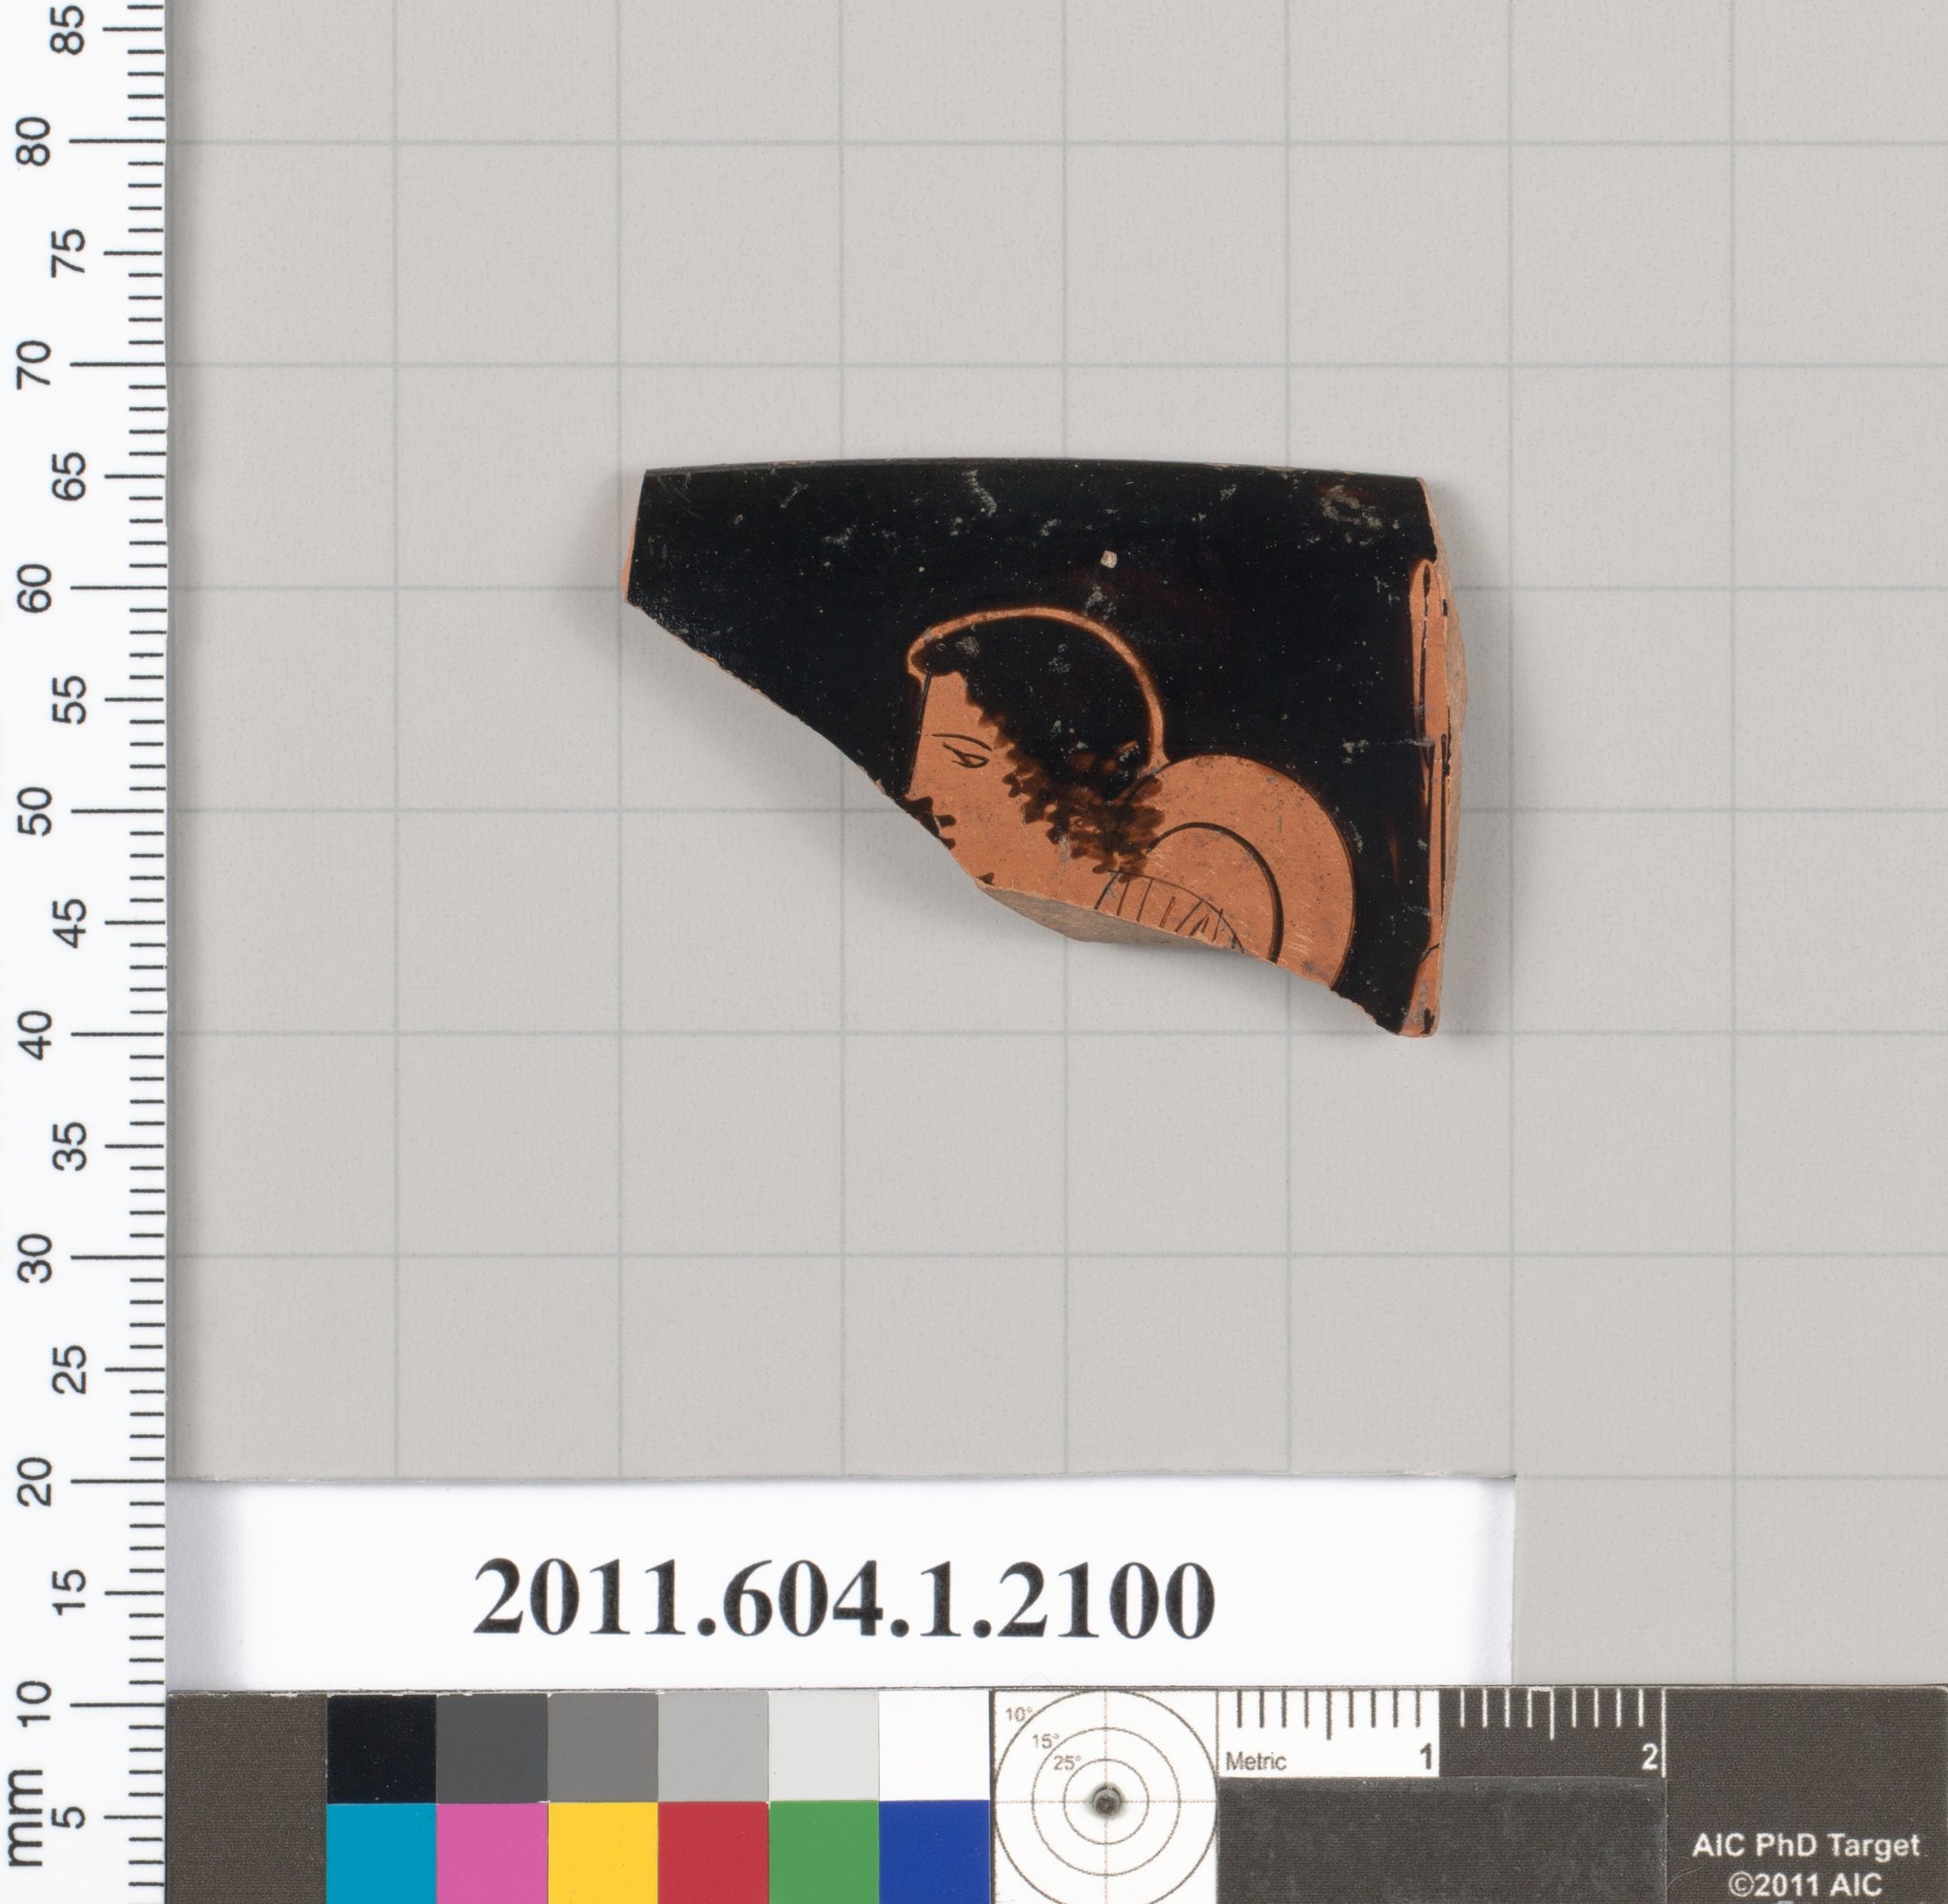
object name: kylix fragment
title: Terracotta rim fragment of a kylix (drinking cup)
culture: greek, attic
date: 467-435 BCE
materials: terracotta